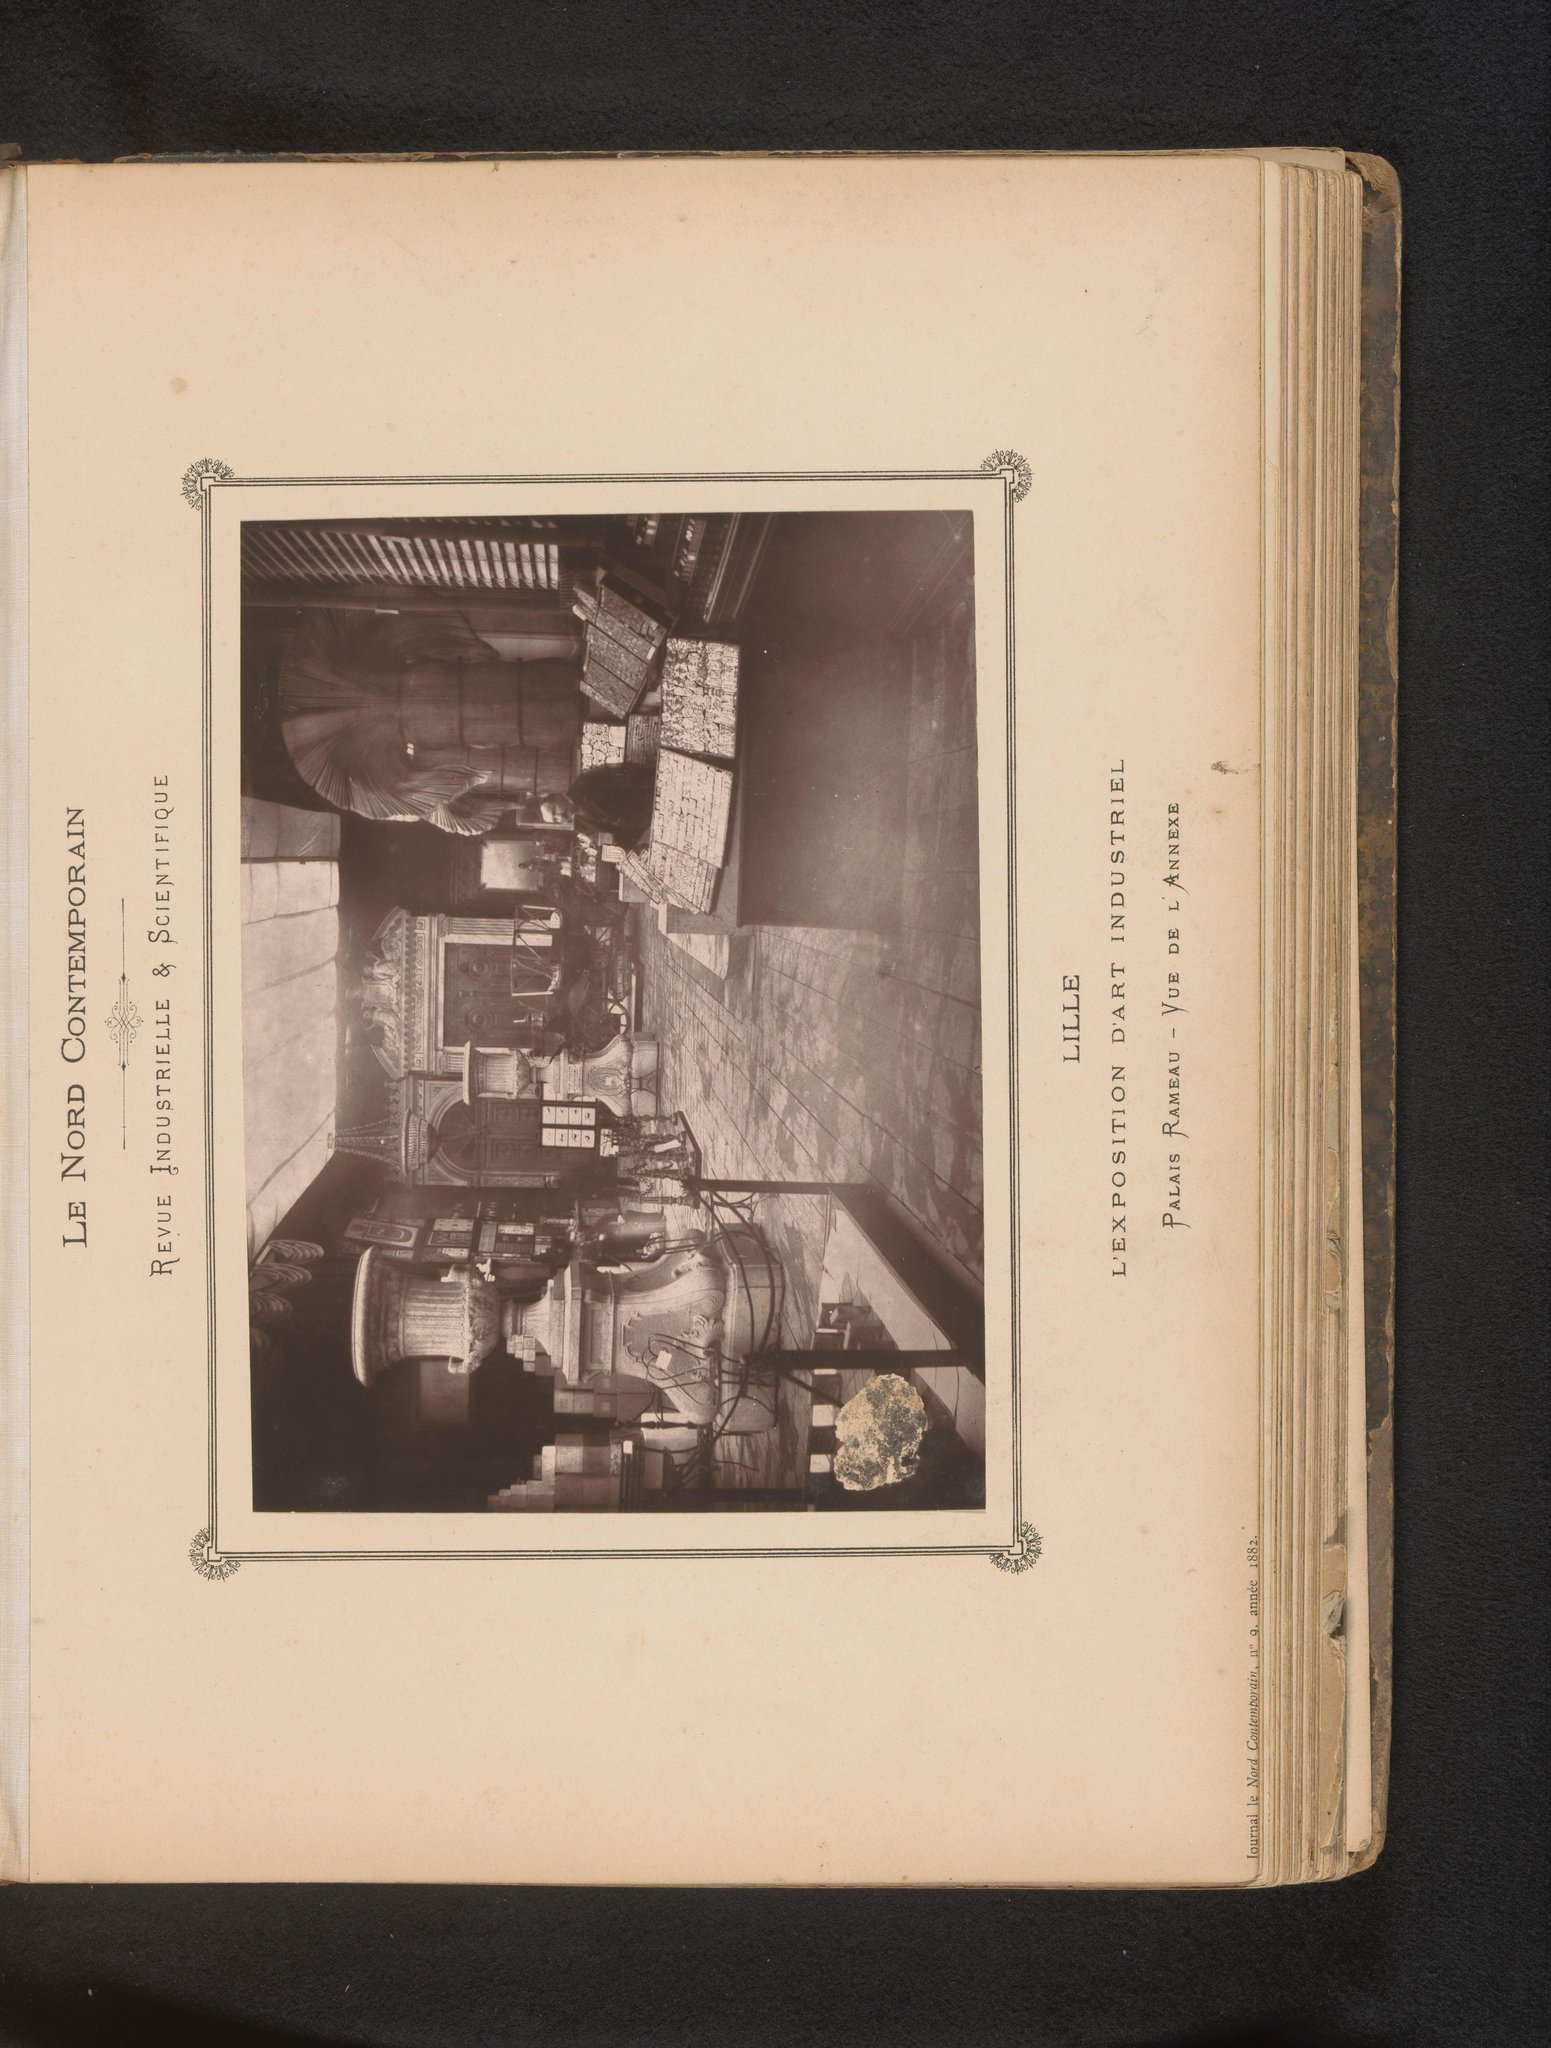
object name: page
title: Interieur van het Palais Rameau met een tentoonstelling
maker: Anonymous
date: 1878-1882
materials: paper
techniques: woodburytype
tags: palace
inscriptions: inscription: ‘Journal le Nord Contemporain, No 9, année 1882’, inscription: ‘Le Nord Contemporain/ Revue Industrielle & Scientifique’, inscription: ‘Palais Rameau - Vue de l'Annexe’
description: Prent op derde ongenummerde pagina na pagina 144.